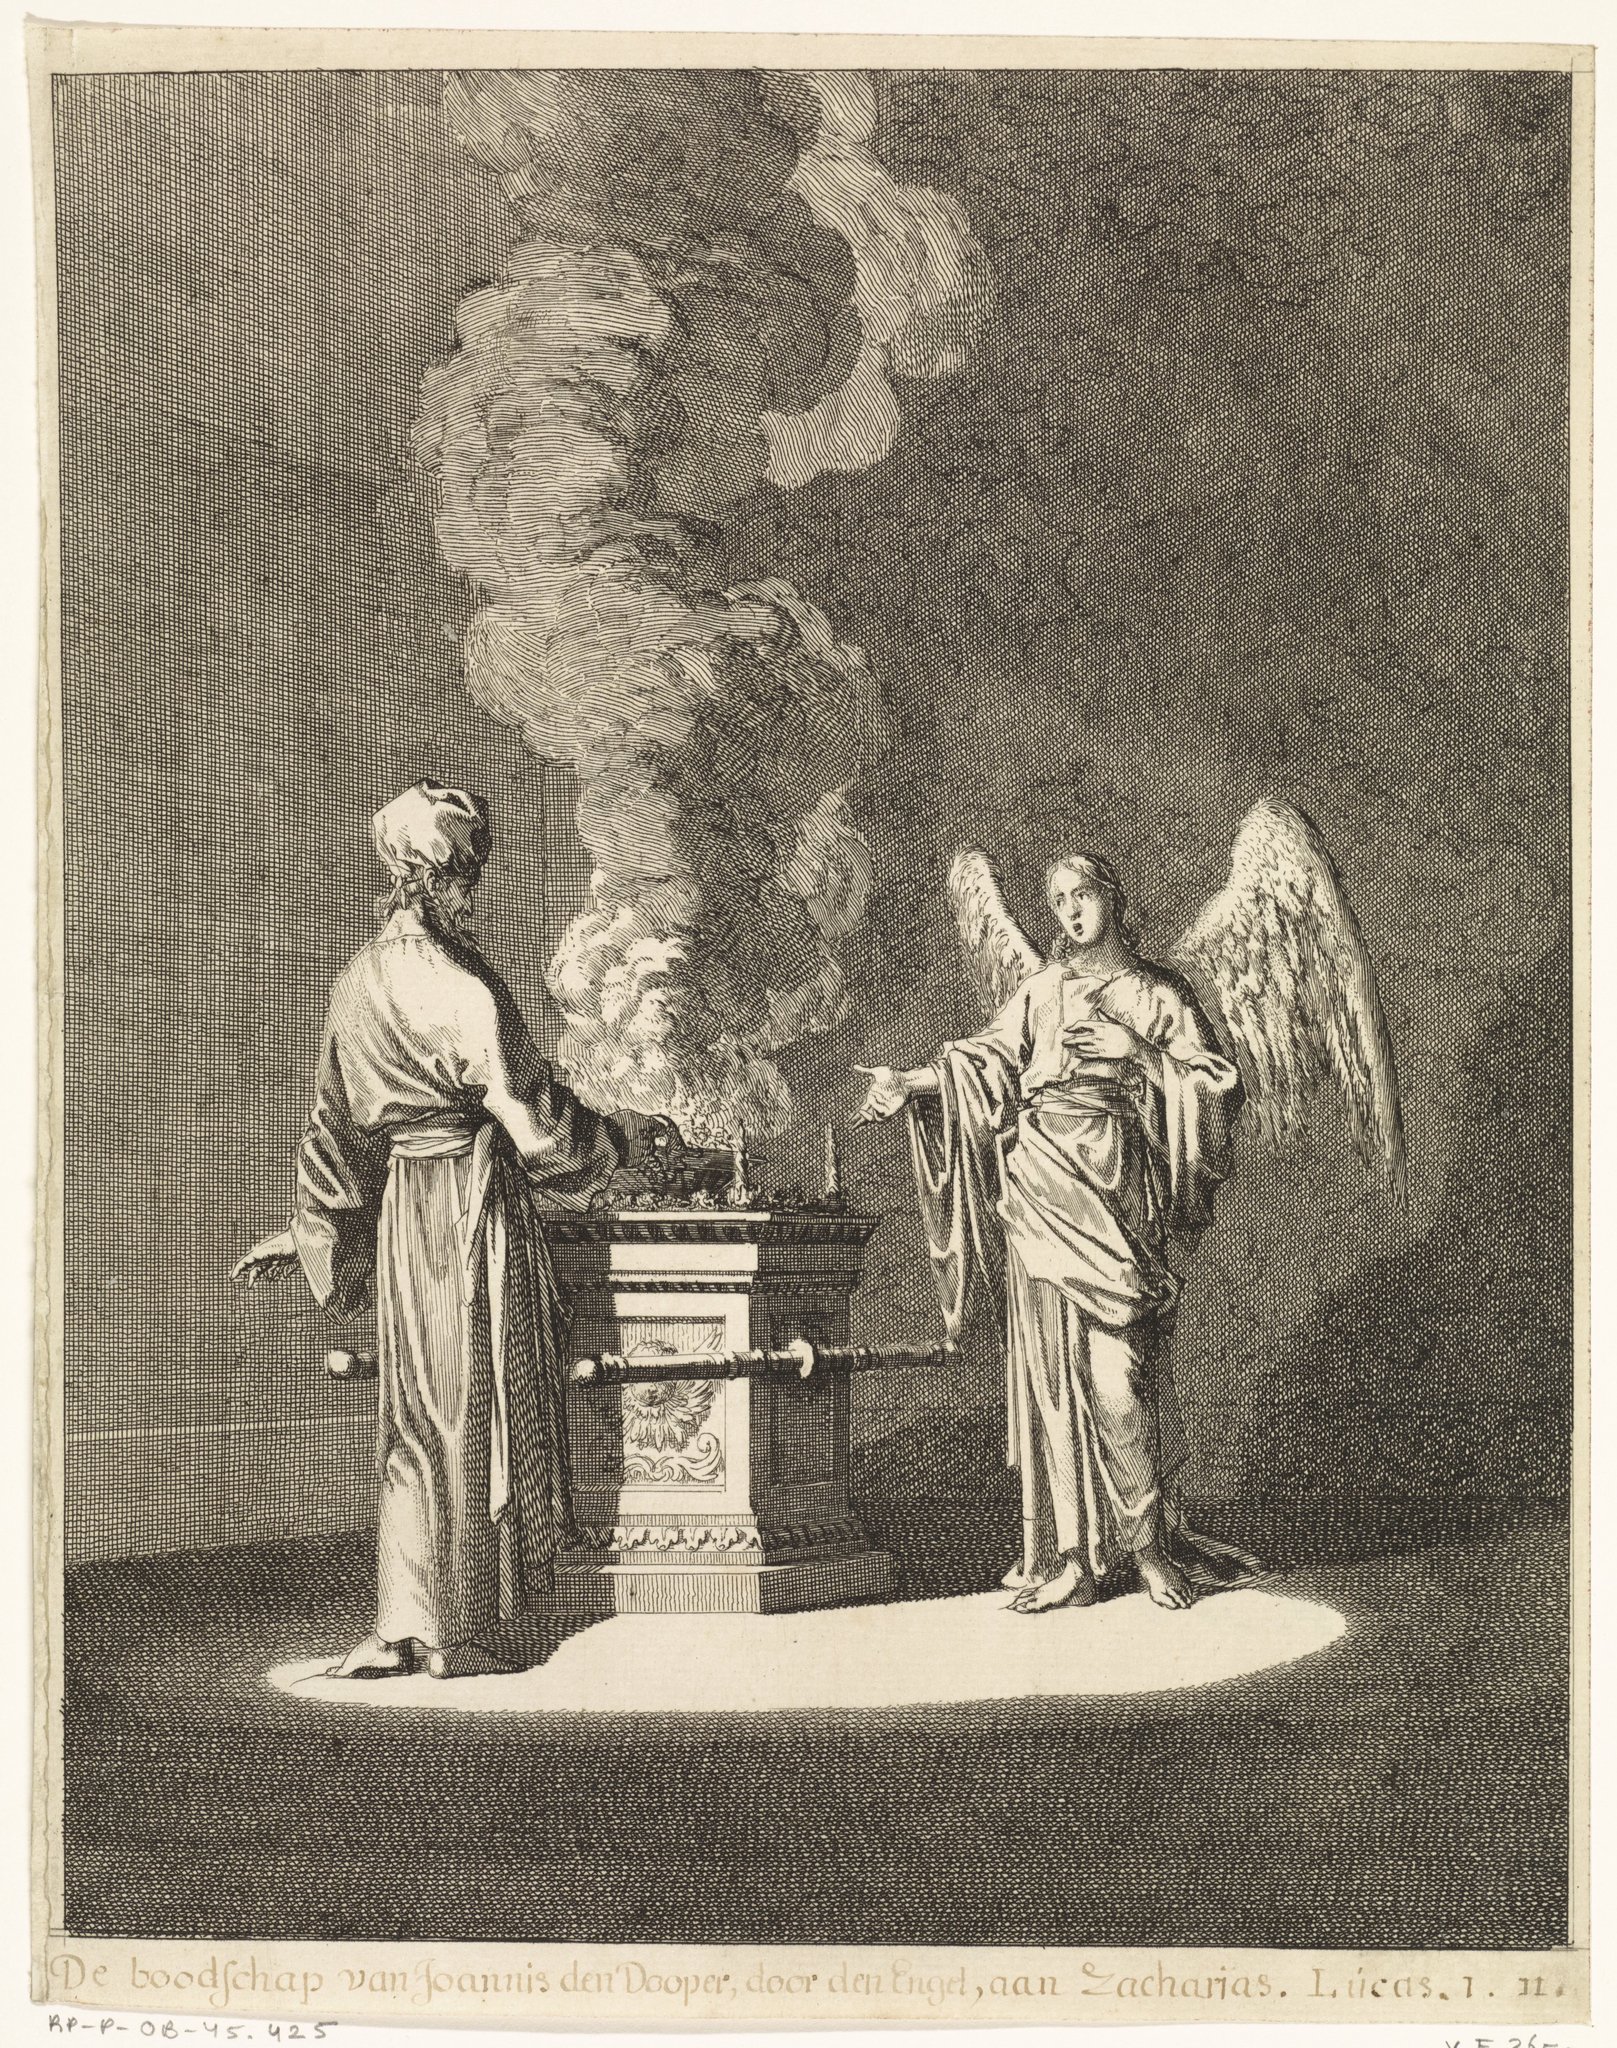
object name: print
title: Aankondiging aan Zacharias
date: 1708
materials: paper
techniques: etching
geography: amsterdam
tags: annunciation of the birth of john the baptist to zacharias: while he is offering incense in the temple an angel (gabriel) appears to him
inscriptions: collector's mark: Lugt 2228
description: Proefdruk van een prent welke is opgenomen als illustratie in: Historiae Celebriores Veteris Testamenti. Christoph Weigel, 1708.